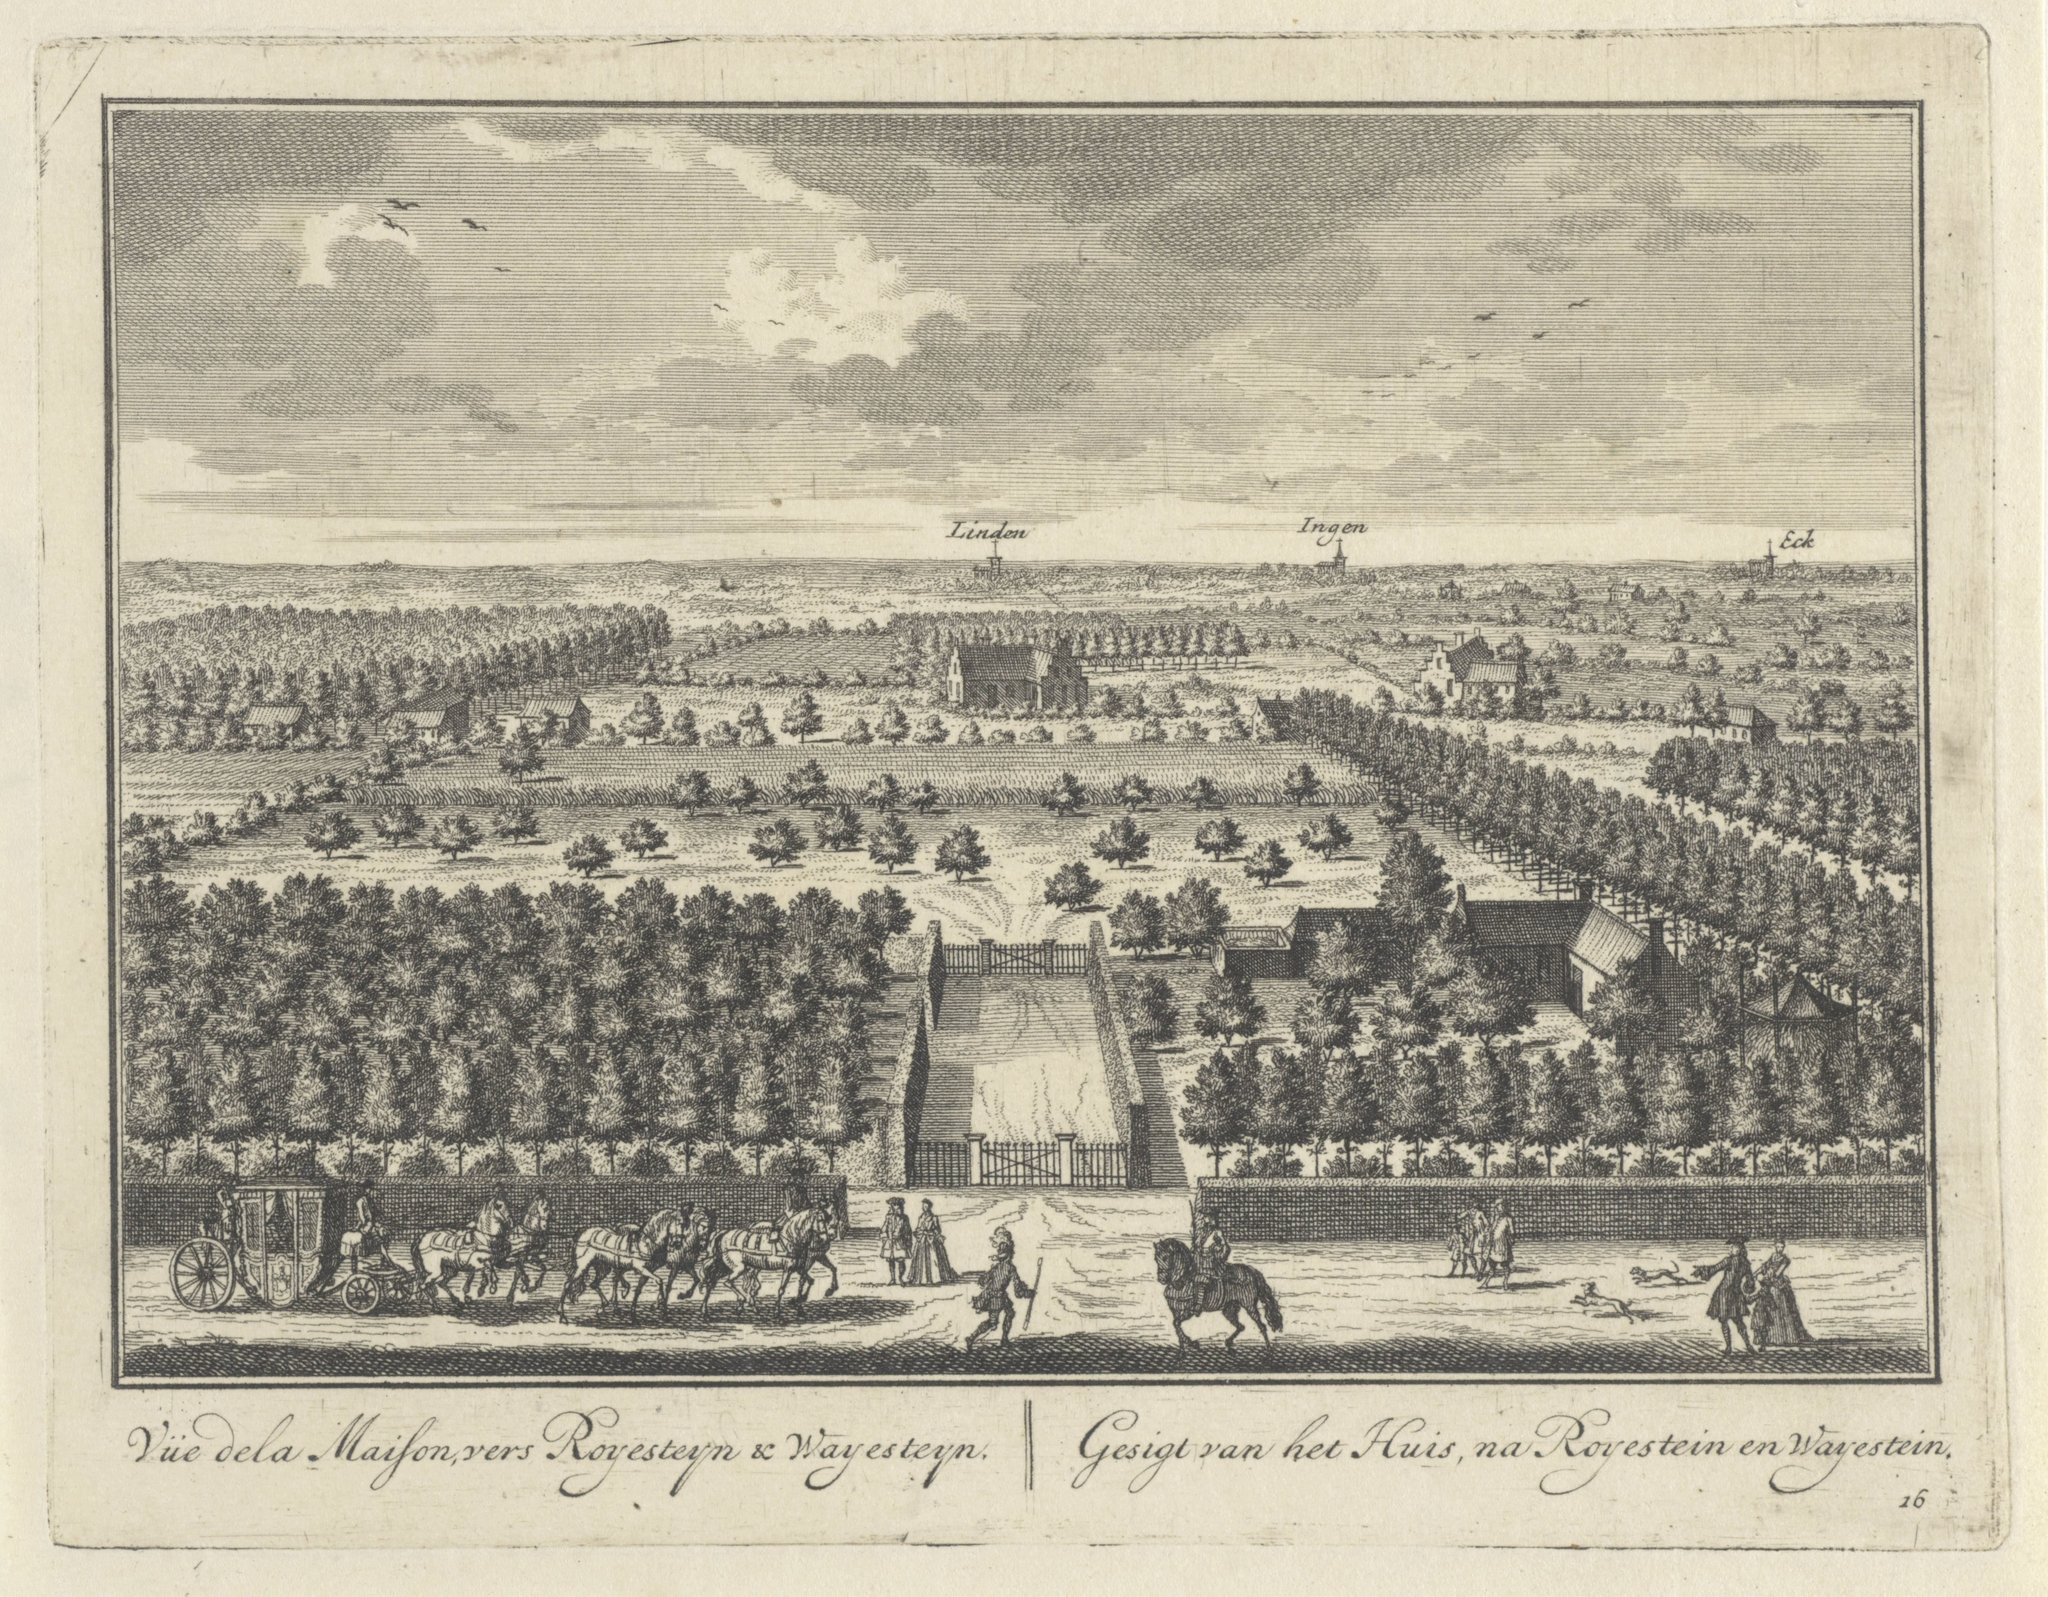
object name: print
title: Tuin en landschap bij Kasteel Zuilenstein gezien in de richting van de Betuwe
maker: daniël stopendaal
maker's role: print maker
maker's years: 1672-1726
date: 1682-1726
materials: paper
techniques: etching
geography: amsterdam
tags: french or architectonic garden; formal garden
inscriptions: collector's mark: Lugt 2228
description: Gezicht vanuit kasteel Zuilenstein te Leersum over de grote toegangslaan van het kasteel en de boomgaard aan de zuidoostzijde, in de richting van de Betuwe, uit het noordwesten.